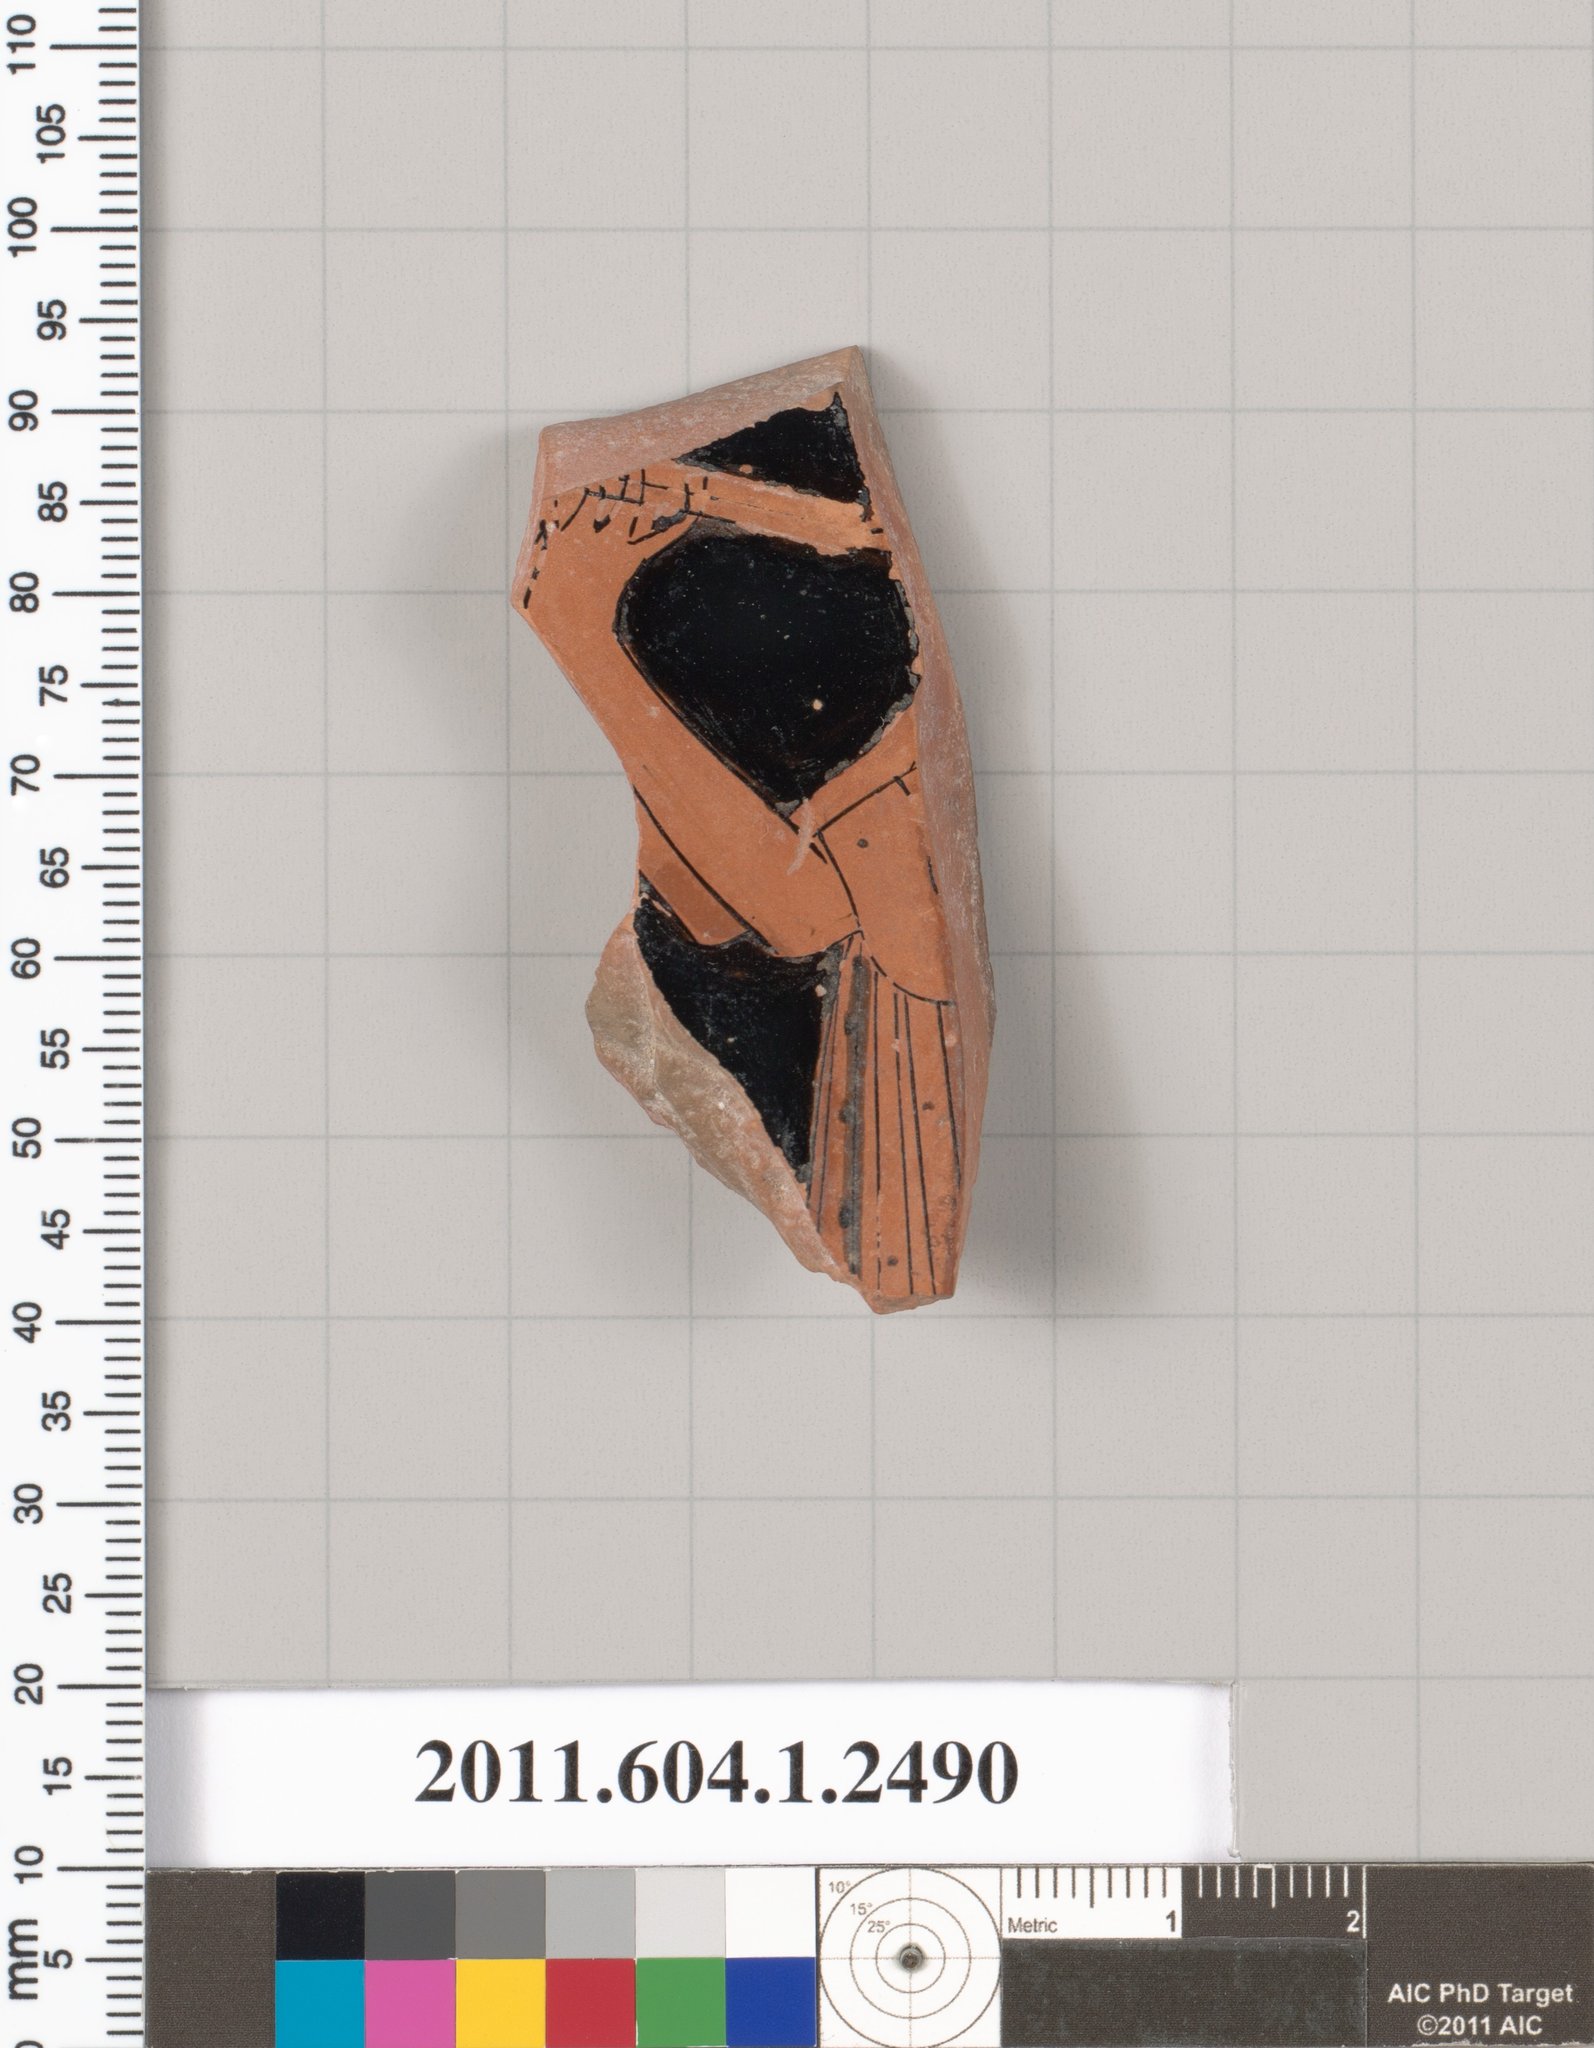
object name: kylix fragment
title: Terracotta fragment of a kylix (drinking cup)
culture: greek, attic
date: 490-480 BCE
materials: terracotta